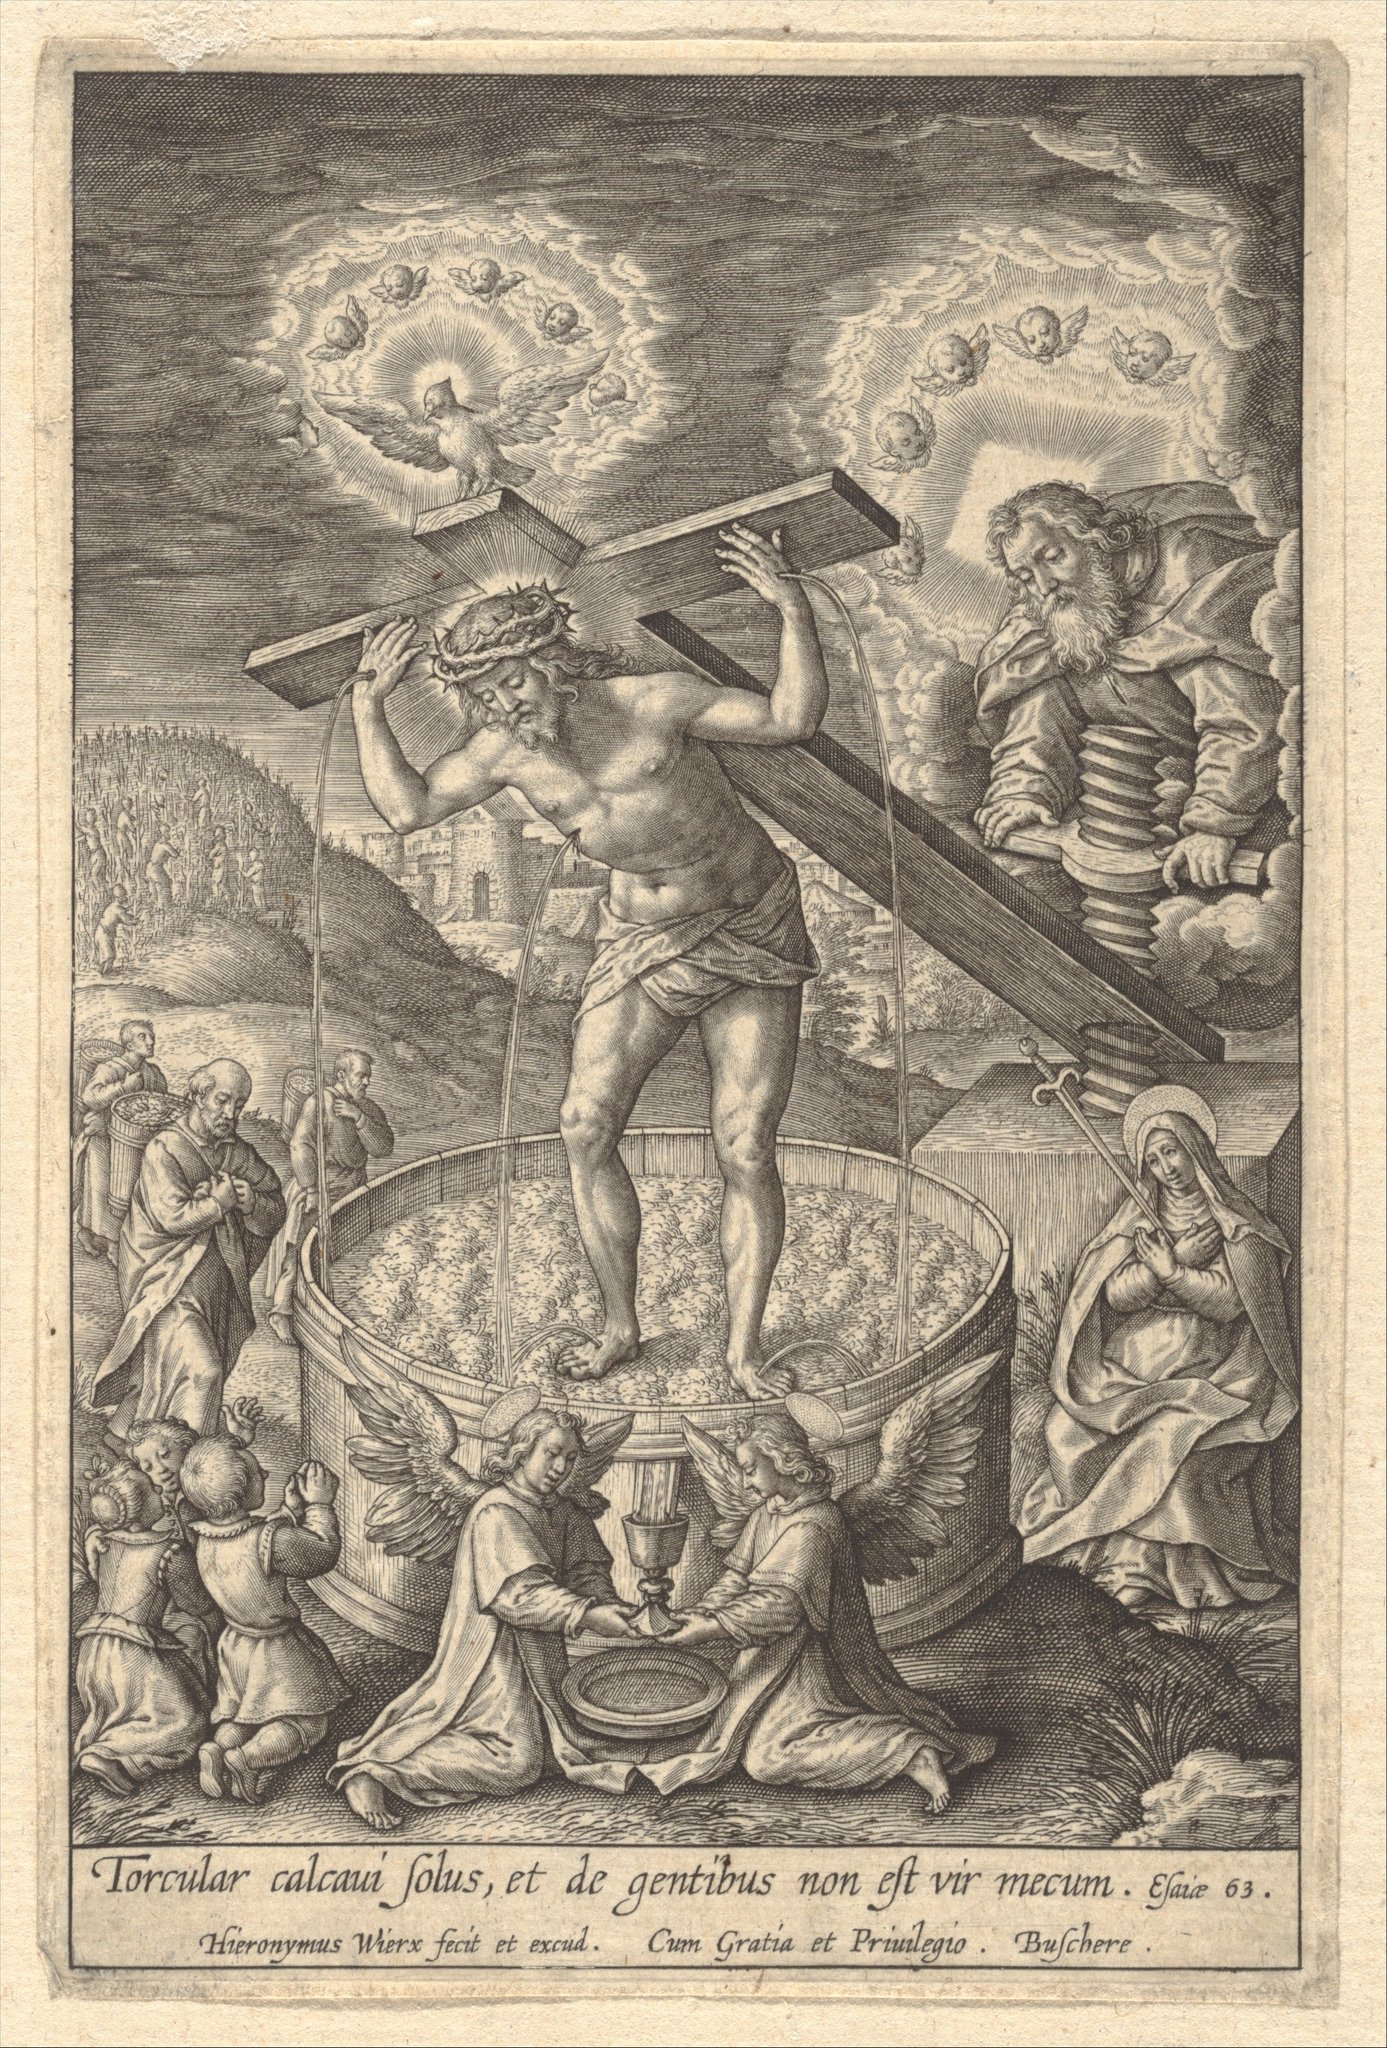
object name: print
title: Christ in the Wine Press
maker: hieronymus wierix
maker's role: artist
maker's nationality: netherlandish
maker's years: 1553-1619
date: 1619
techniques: engraving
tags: women,angels,christ,cross